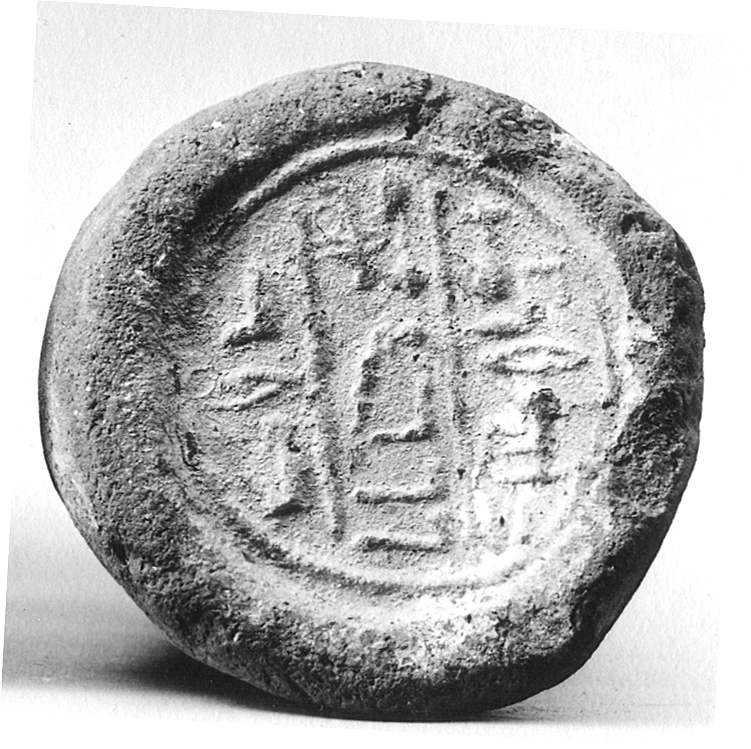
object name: cone, circular impression, nefretper, cup bearer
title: Funerary Cone of the Royal Cup-Bearer Nefretper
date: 1550-1295 BCE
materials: pottery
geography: egypt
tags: hieroglyphs